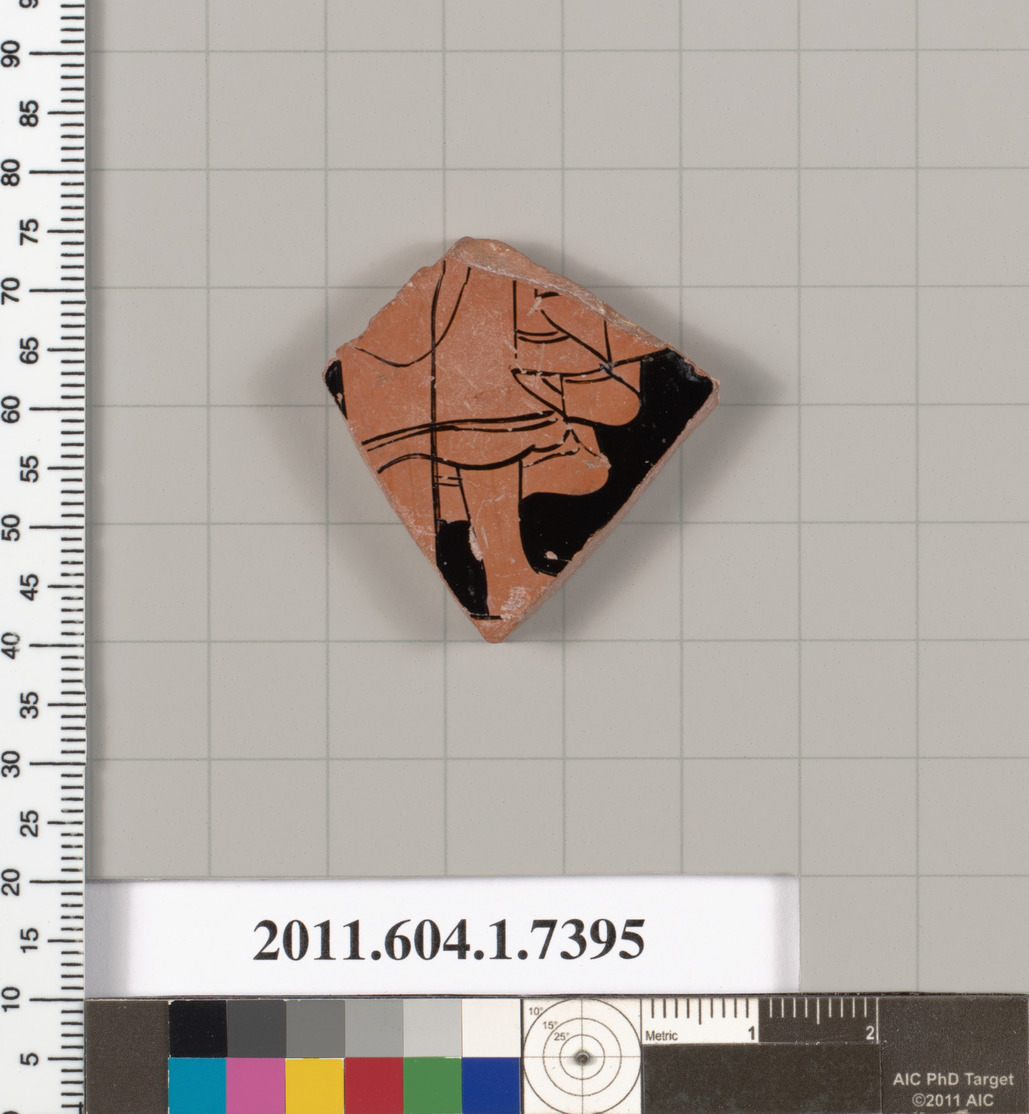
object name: kylix fragment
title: Terracotta fragment of a kylix (drinking cup)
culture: greek, attic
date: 500-480 BCE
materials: terracotta